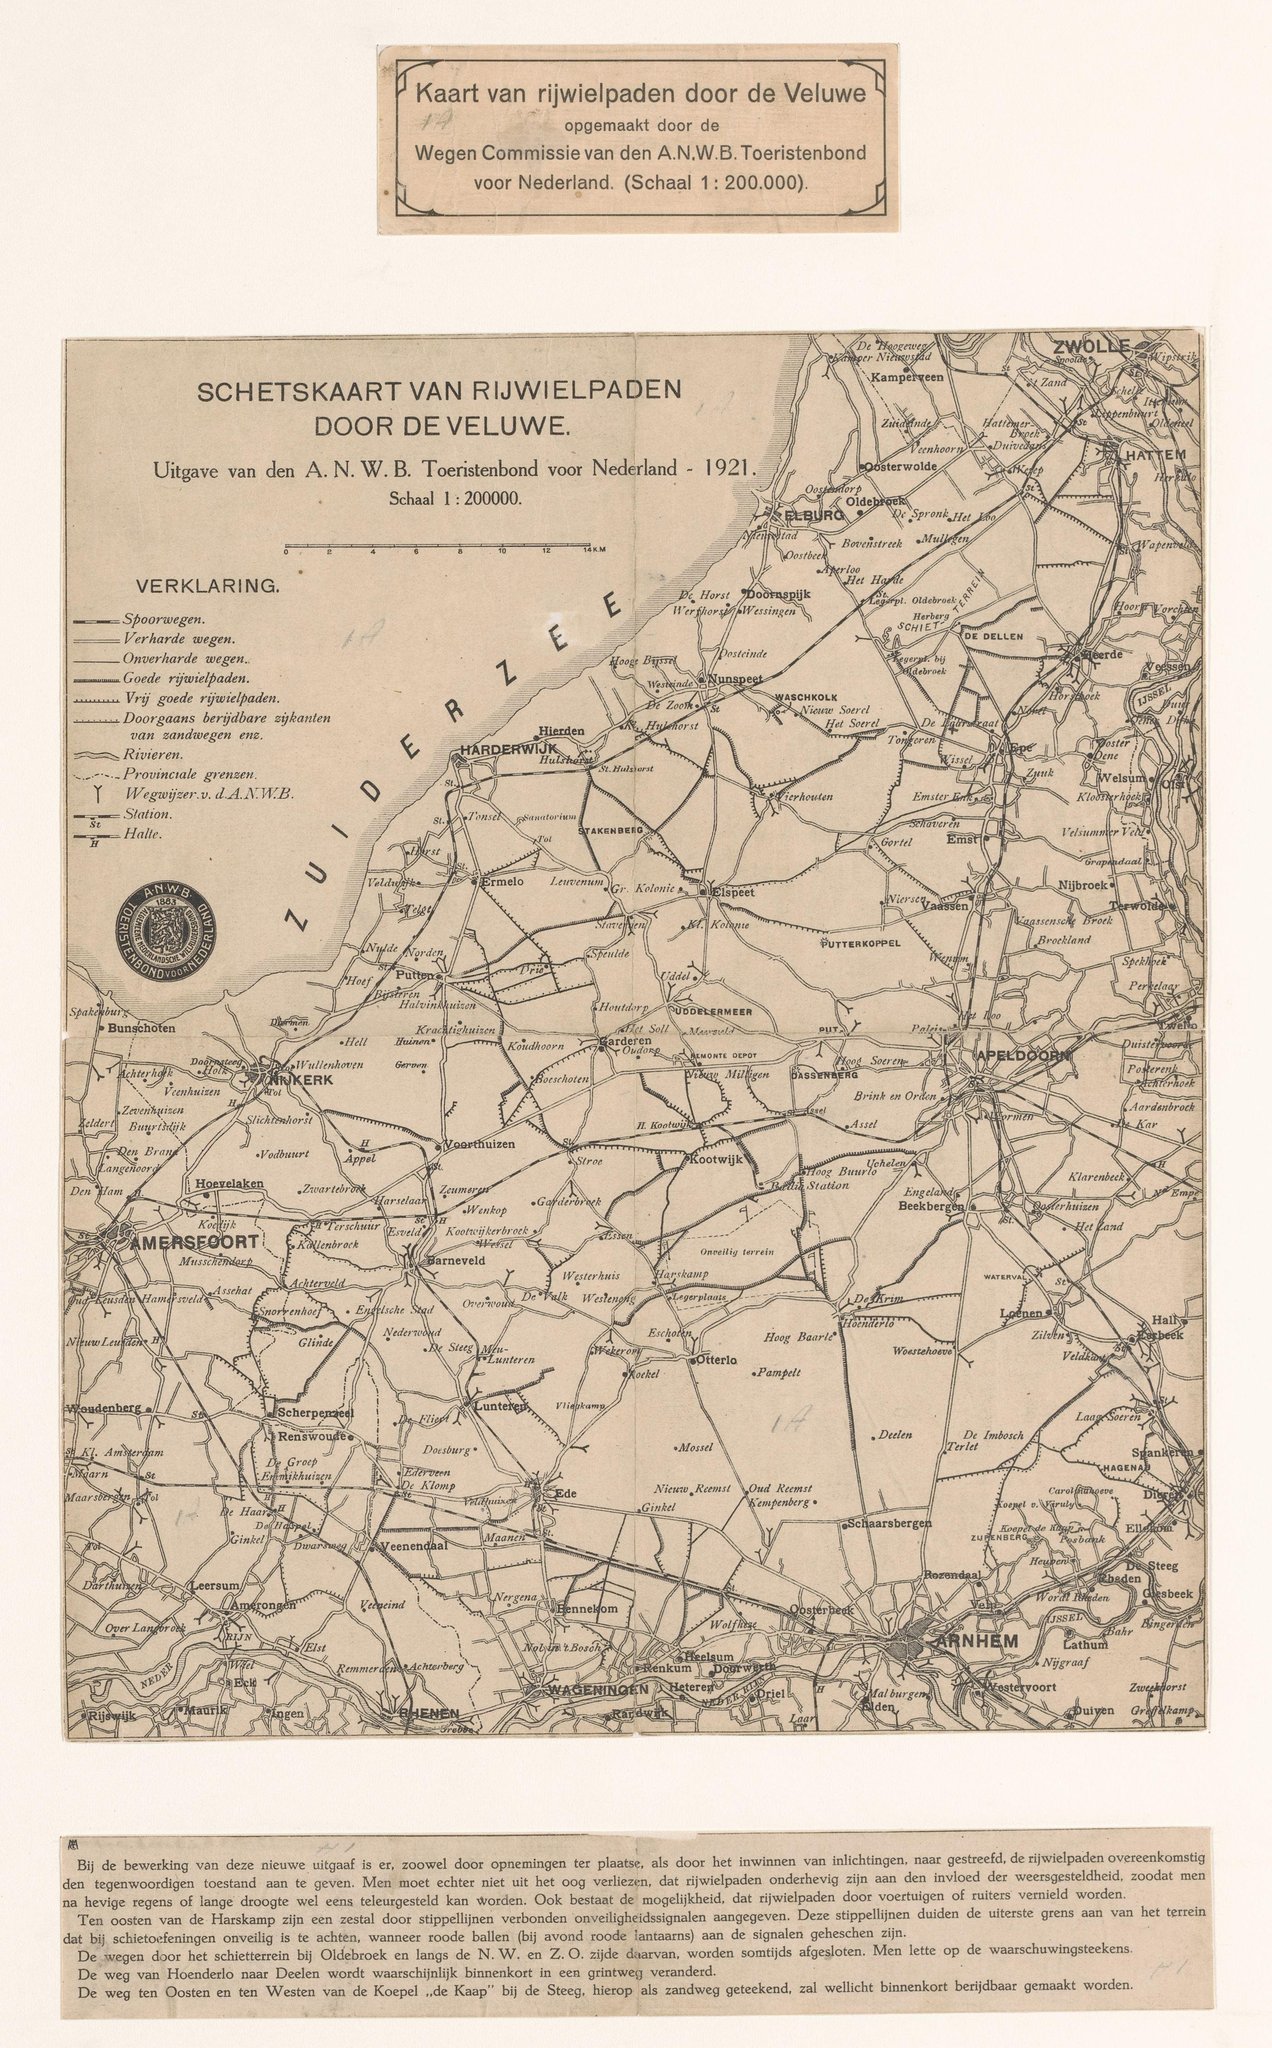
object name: print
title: Schetskaart van rijwielpaden door de Veluwe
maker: Anonymous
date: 1921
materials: paper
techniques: lithograph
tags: riding, cycling (recreation), maps of separate countries or regions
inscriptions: date